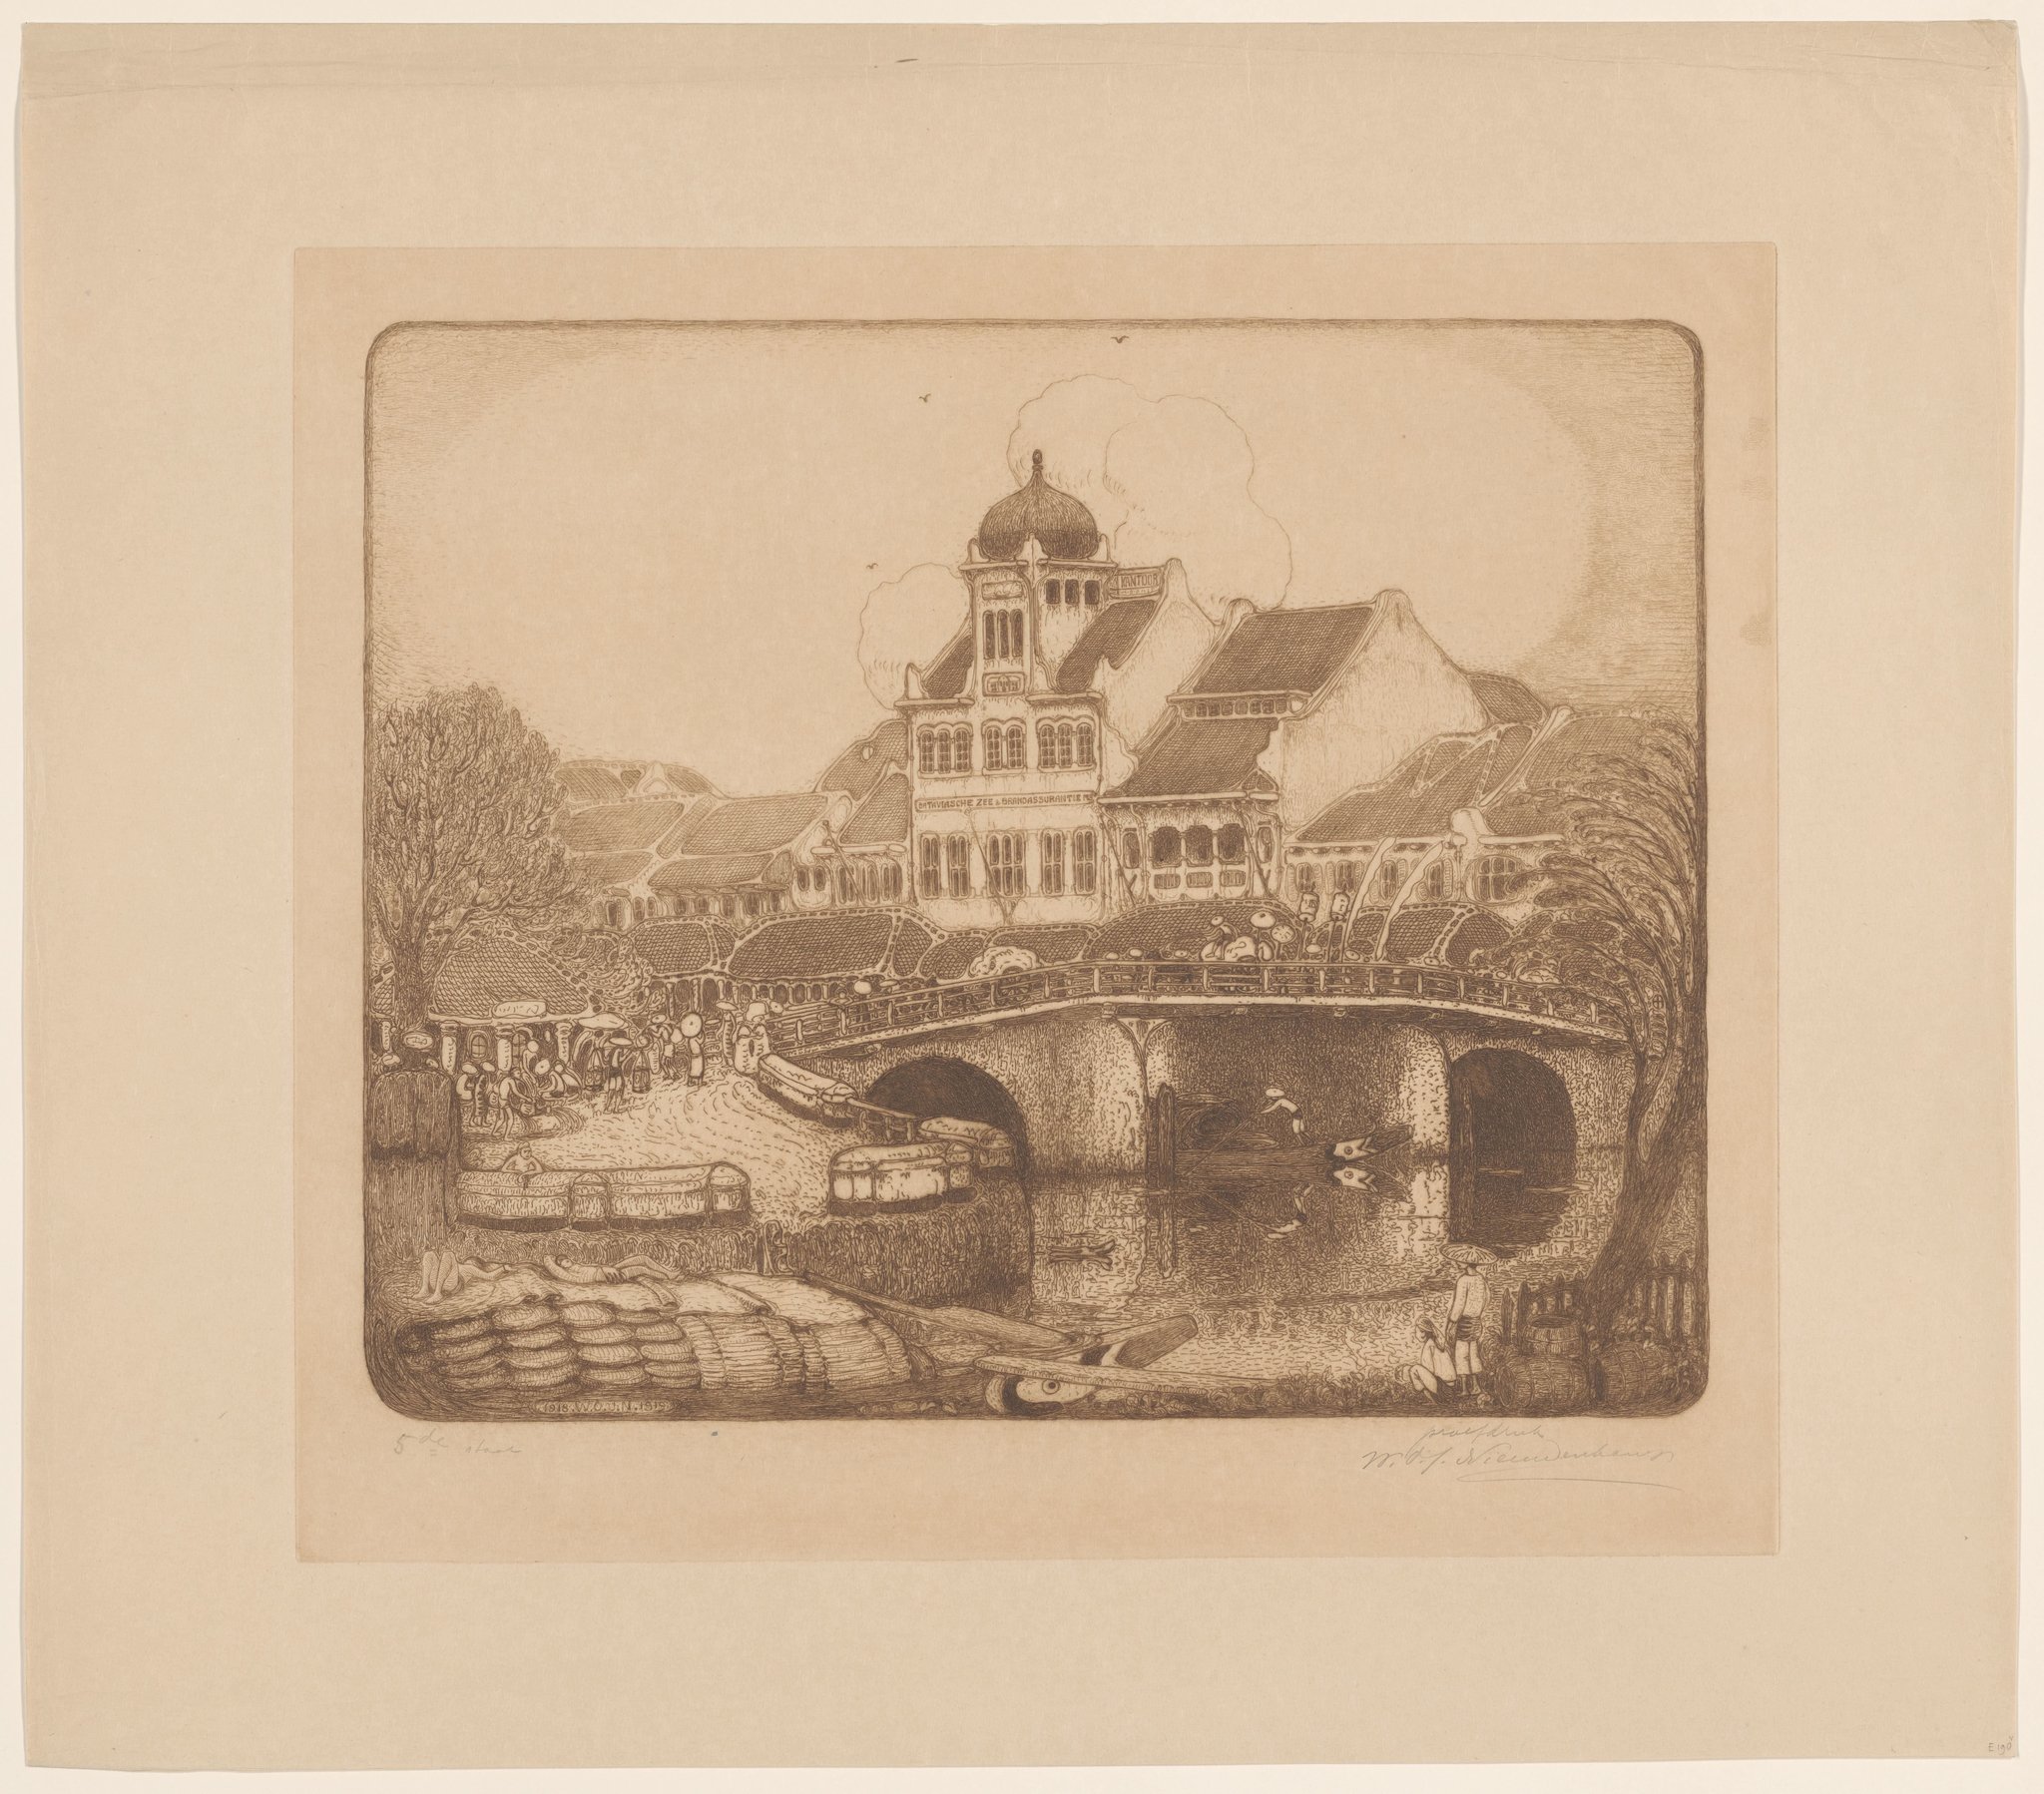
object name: print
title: Het Kantoorgebouw van de Firma Sluyters & Co. Kali Besar Batavia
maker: wijnand otto jan nieuwenkamp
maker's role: draughtsman, print maker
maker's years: 1874-1950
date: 1919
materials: paper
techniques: etching, intaglio, retroussage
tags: housing, bridge, gondola, batavia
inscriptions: collector's mark: Lugt 2233